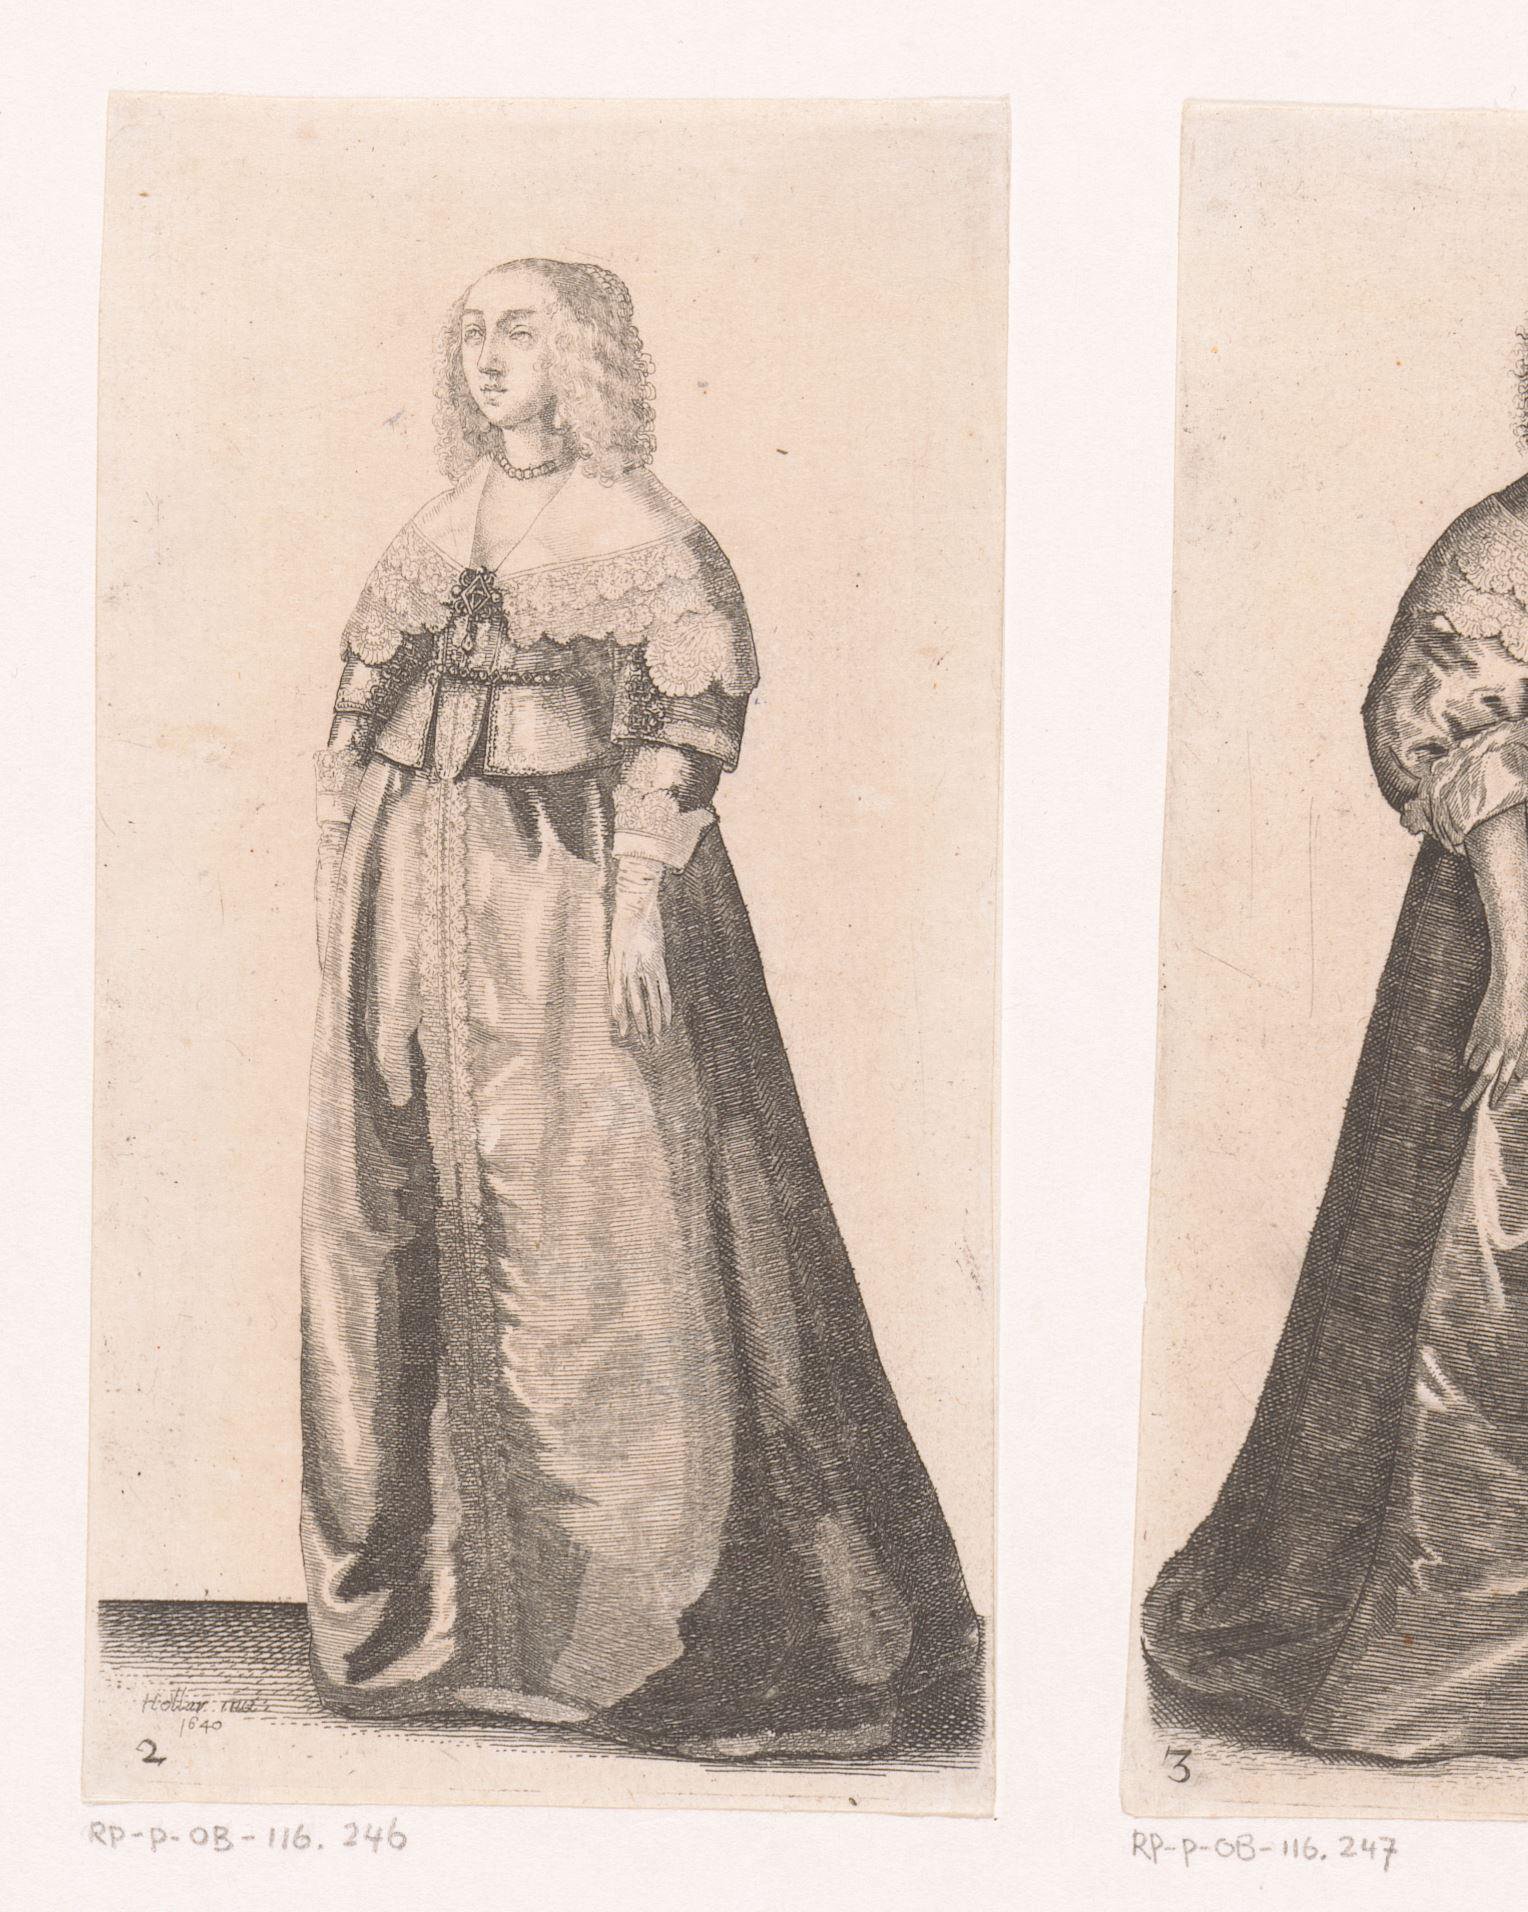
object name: costume print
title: Engelse vrouw van stand, een gordel met edelstenen om het middel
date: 1640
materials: paper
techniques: etching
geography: london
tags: ear-rings (+ women's clothes), brooch, agraffe, clasp (+ women's clothes), gloves, mittens (long gloves) (+ women's clothes), neck-gear ~ clothing (neckerchief) (+ women's clothes), europeans: englishmen (+ women), styles of hairdress - aa - ~ women, fashion, clothing (+ lace used for clothes), neck-gear: collar (+ women's clothes), fashion plates, clothes, costume (+ women's clothes), dress, gown (+ women's clothes), pearl; pearl necklace (+ women's clothes)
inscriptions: collector's mark: Lugt 2760, collector's mark: Lugt 2228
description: Engelse dame met gekruld loshangend haar, gekleed in japon met brede platte kanten kraag en kanten manchetten aan de mouwen, waaronder ze handschoenen draagt. Om haar hals een parelketting en een juweel. Een snoer met edelstenen als ceintuur om de taille.